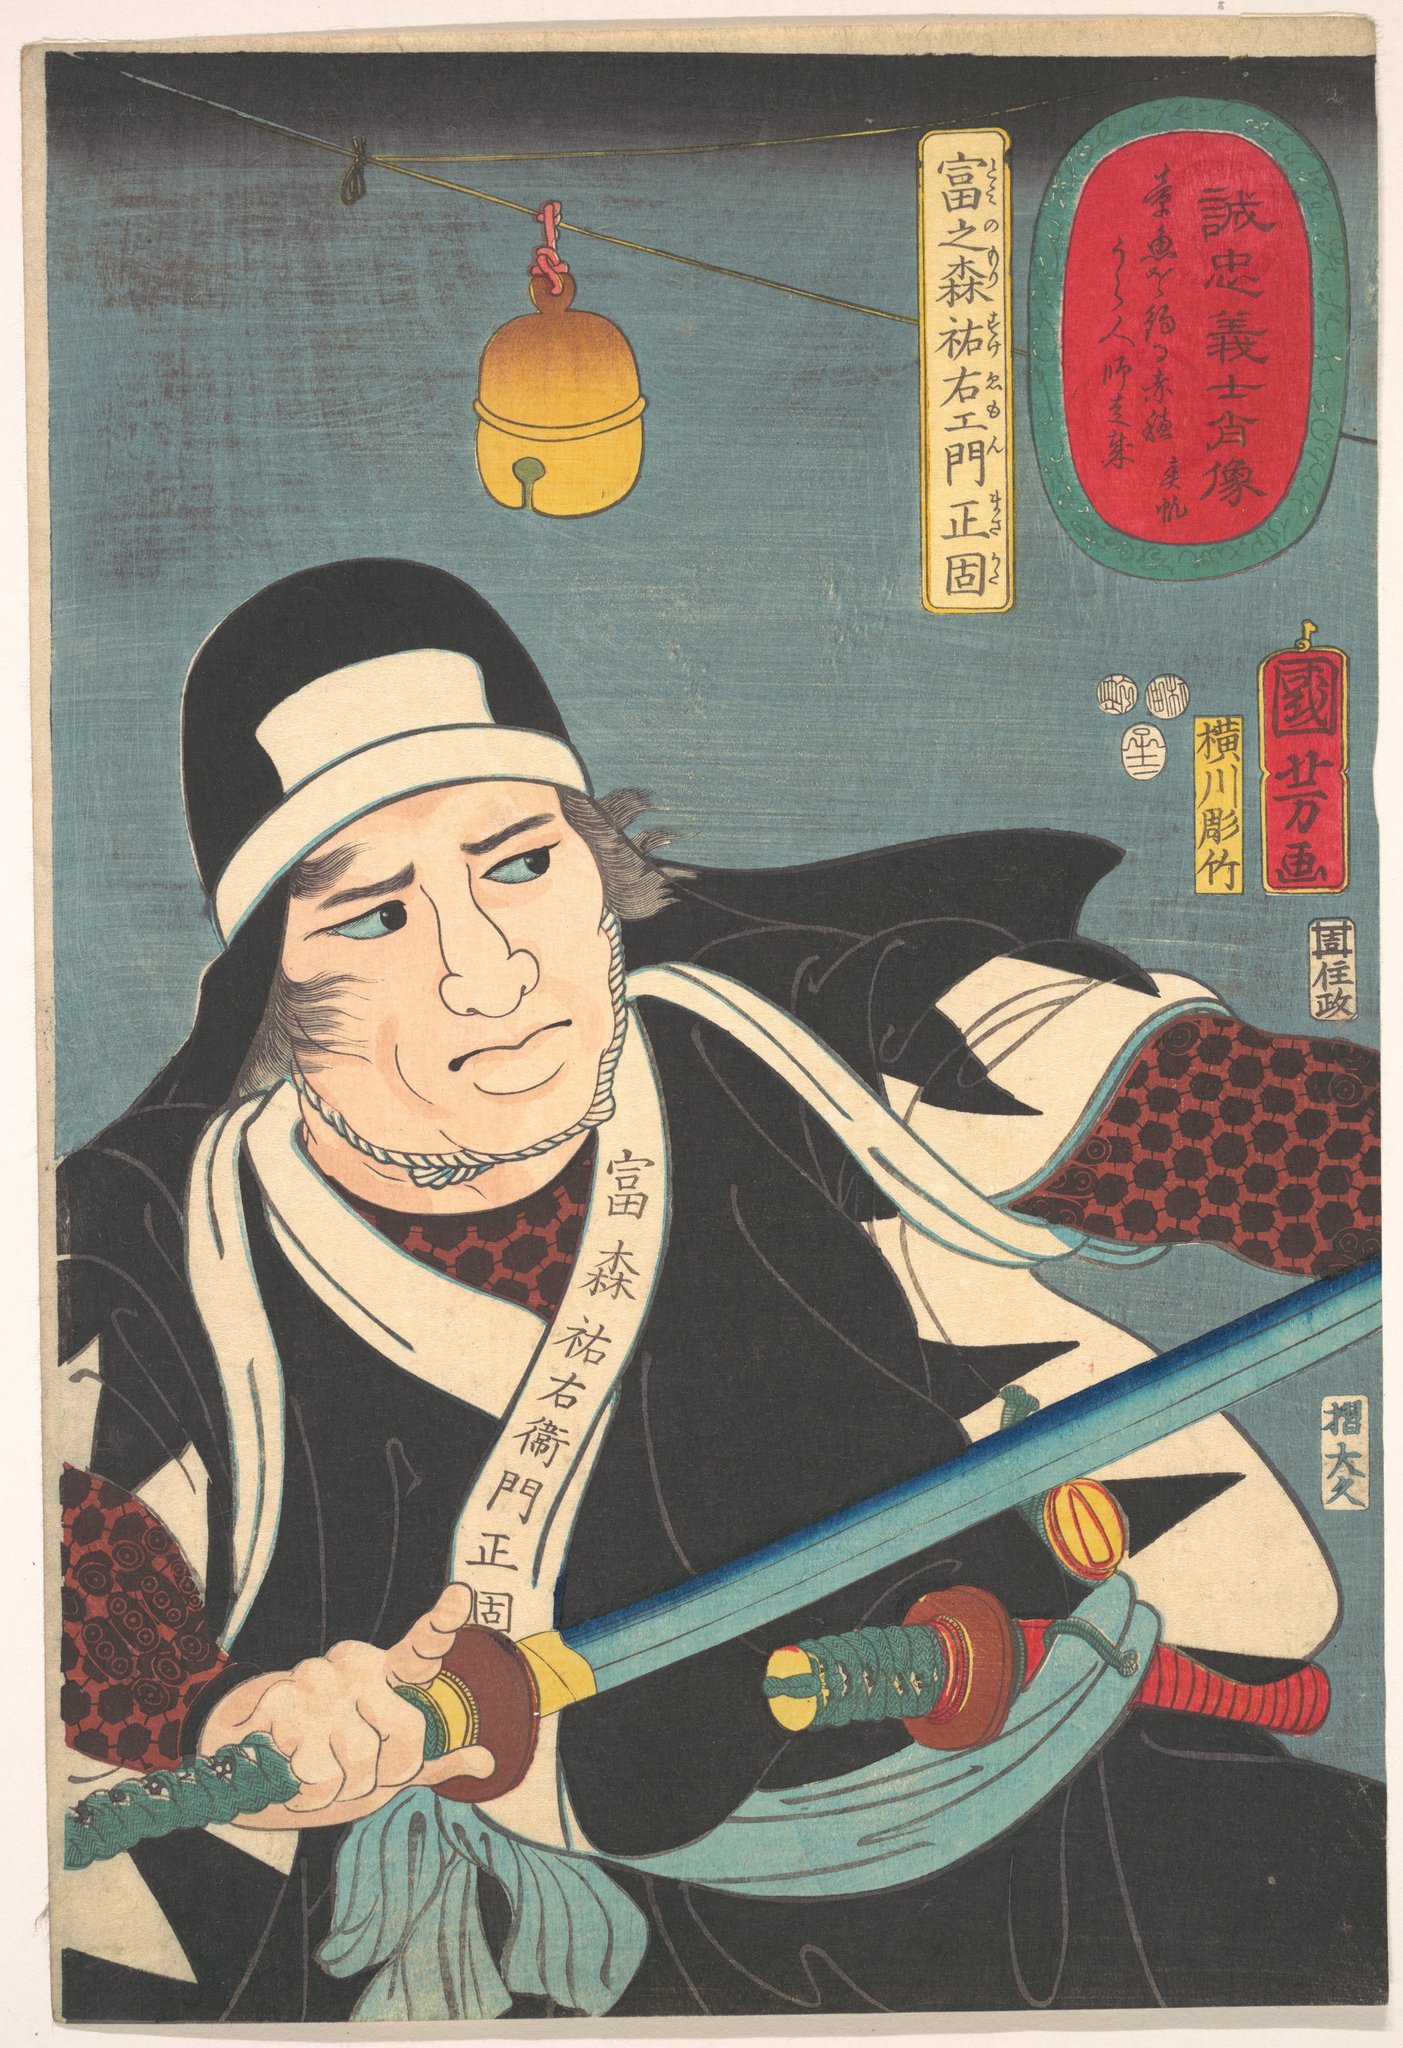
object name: print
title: Portrait of Tominomori Sukeyemon Masakata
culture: japanese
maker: utagawa kuniyoshi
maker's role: artist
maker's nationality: japanese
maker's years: 1797-1861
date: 1852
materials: ink, paper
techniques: woodblock print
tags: swords,men,portraits